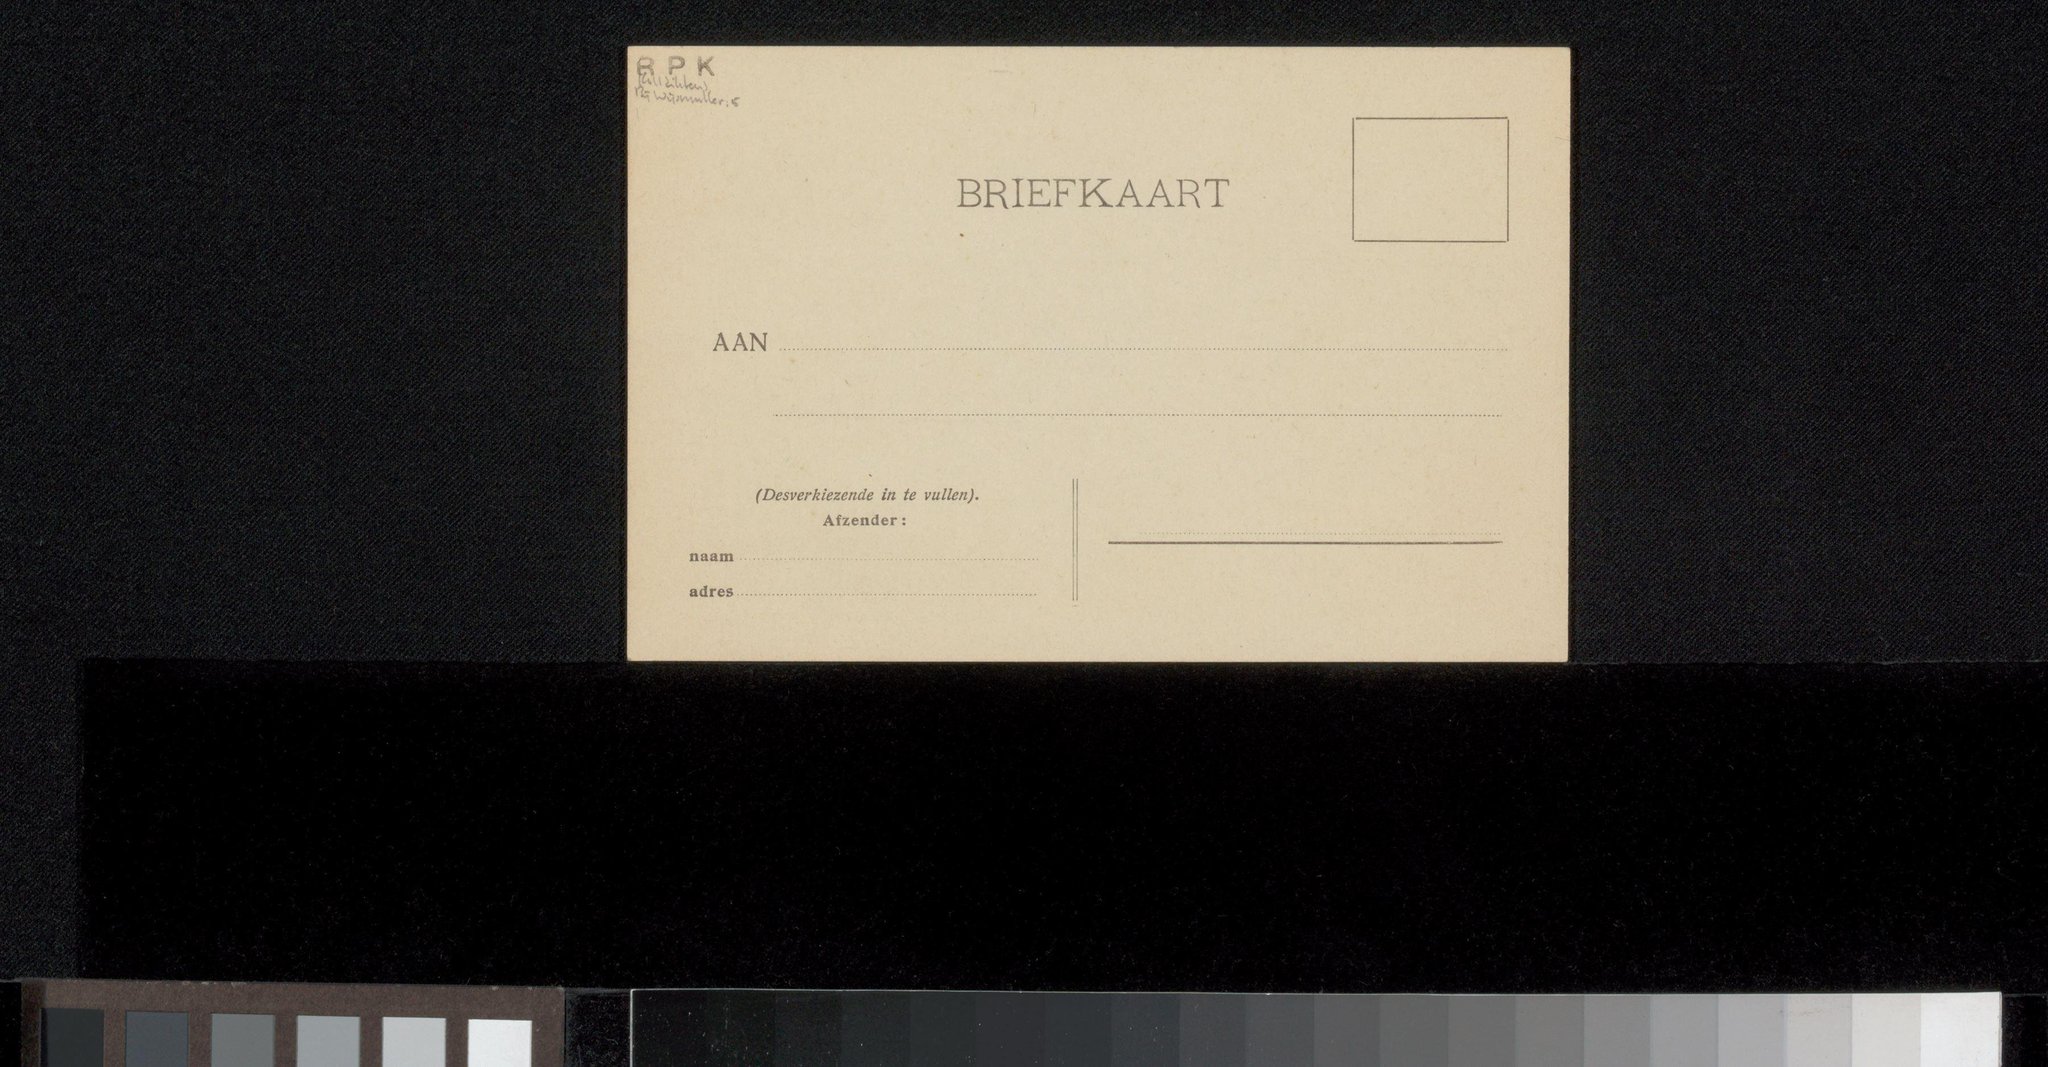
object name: postcard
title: Briefkaart aan Philip Zilcken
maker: jan hillebrand wijsmuller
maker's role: painter, print maker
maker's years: 1855-1925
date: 1911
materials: cardboard, ink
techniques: pen, writing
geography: amsterdam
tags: painter, draughtsman, philip zilcken, printed matter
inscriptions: collector's mark: ‘RPK’